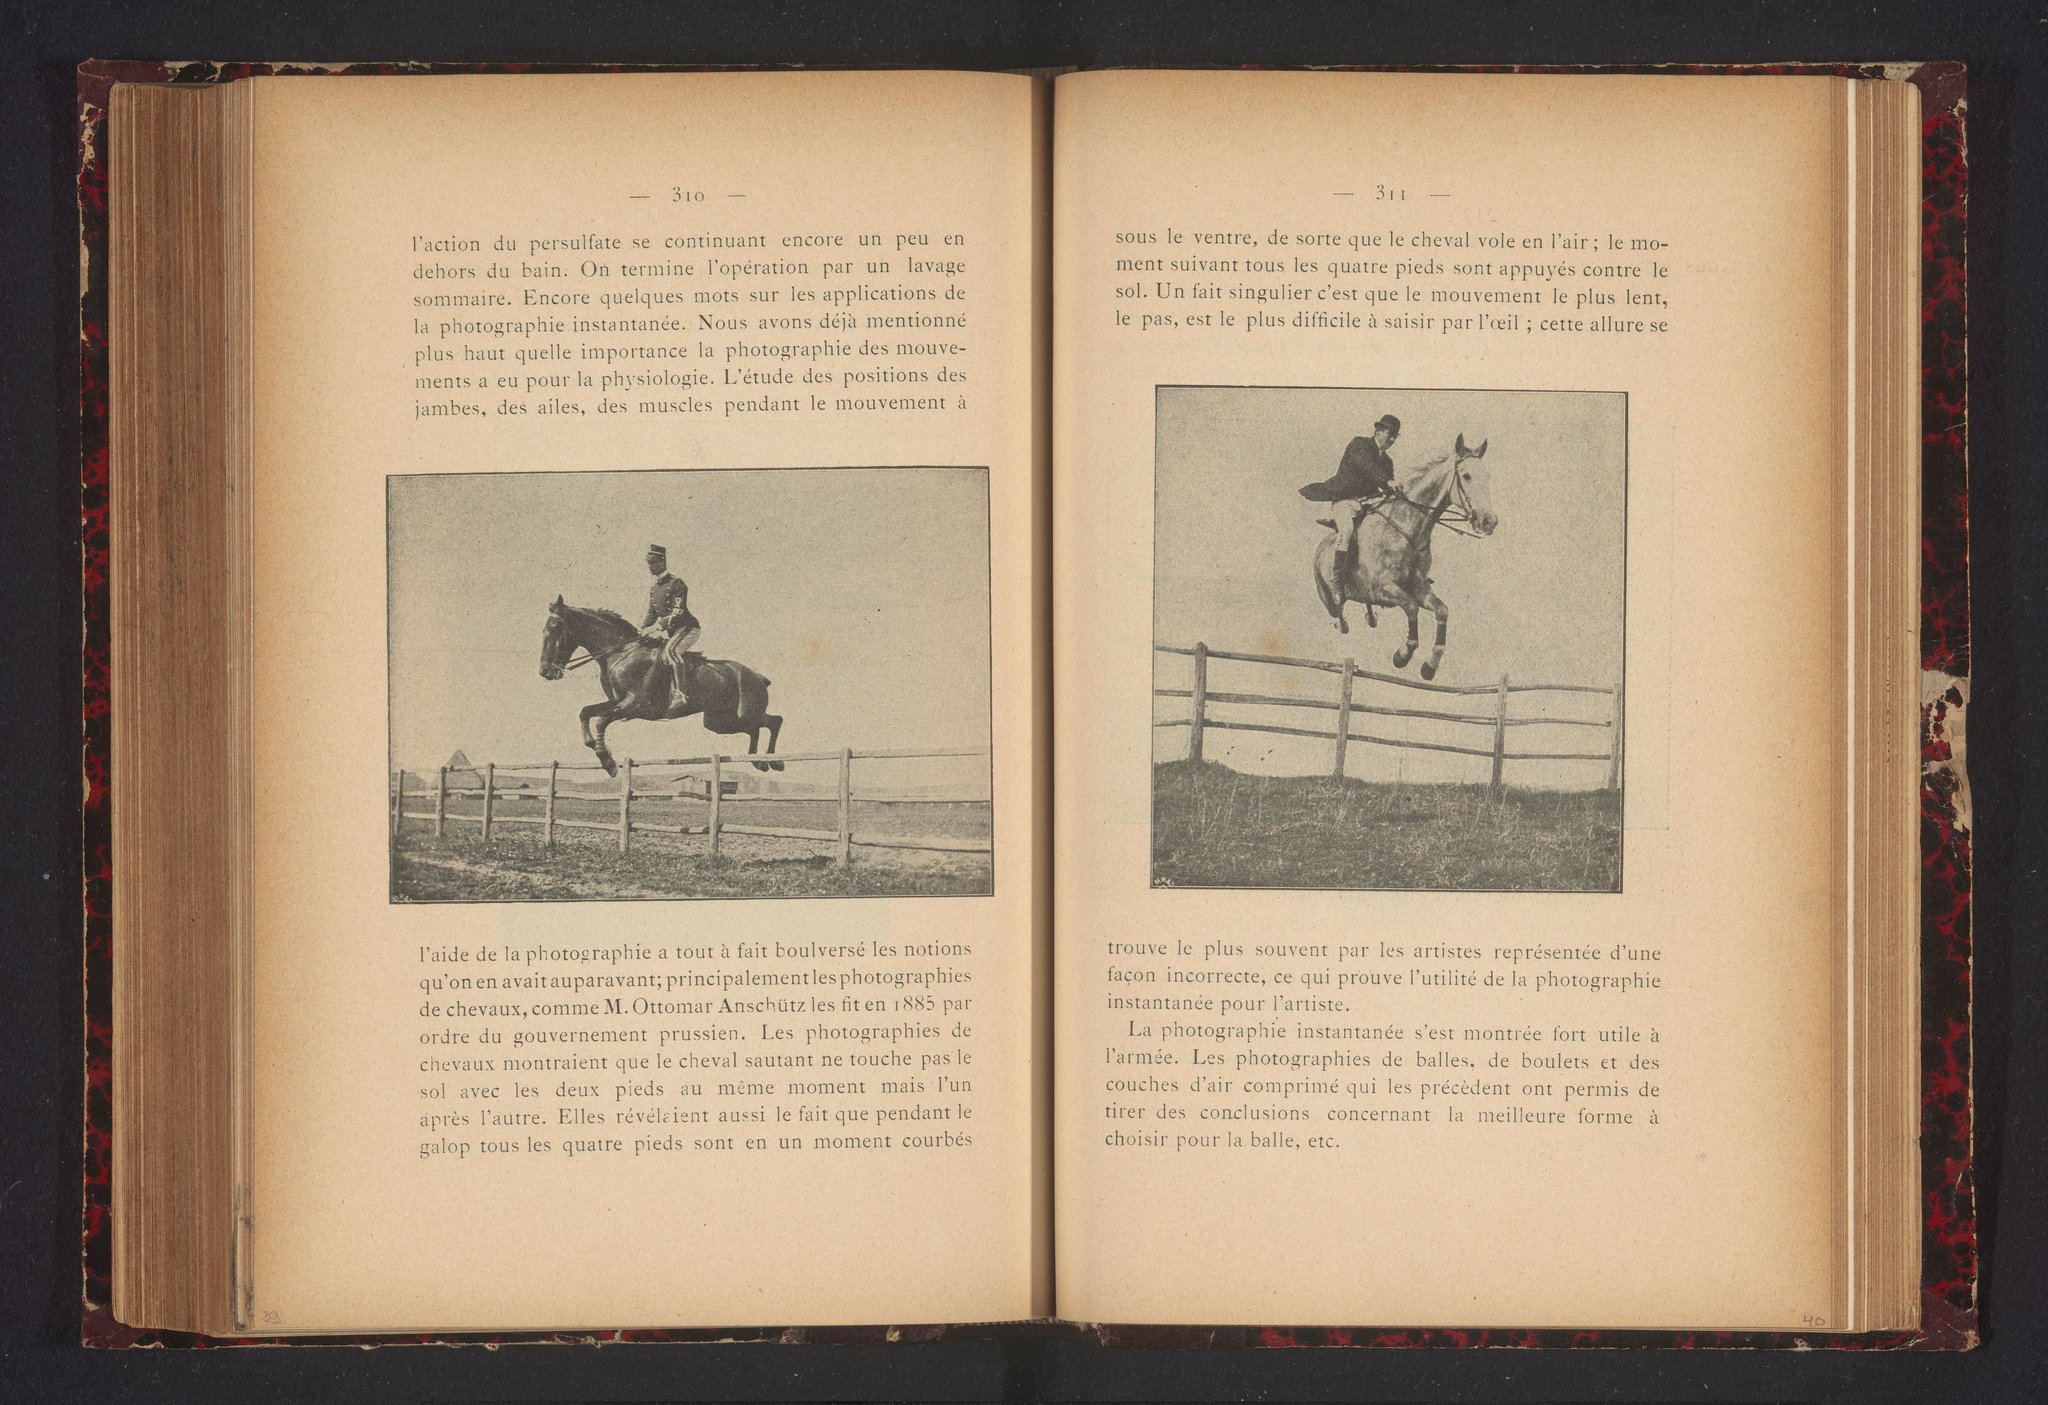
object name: page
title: Paard met ruiter springt over een hek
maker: Anonymous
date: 1894-1899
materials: paper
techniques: autotype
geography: munich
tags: riding a horse, ass, or mule; rider, horseman, fence, wall, paling, jumping (horse in motion)